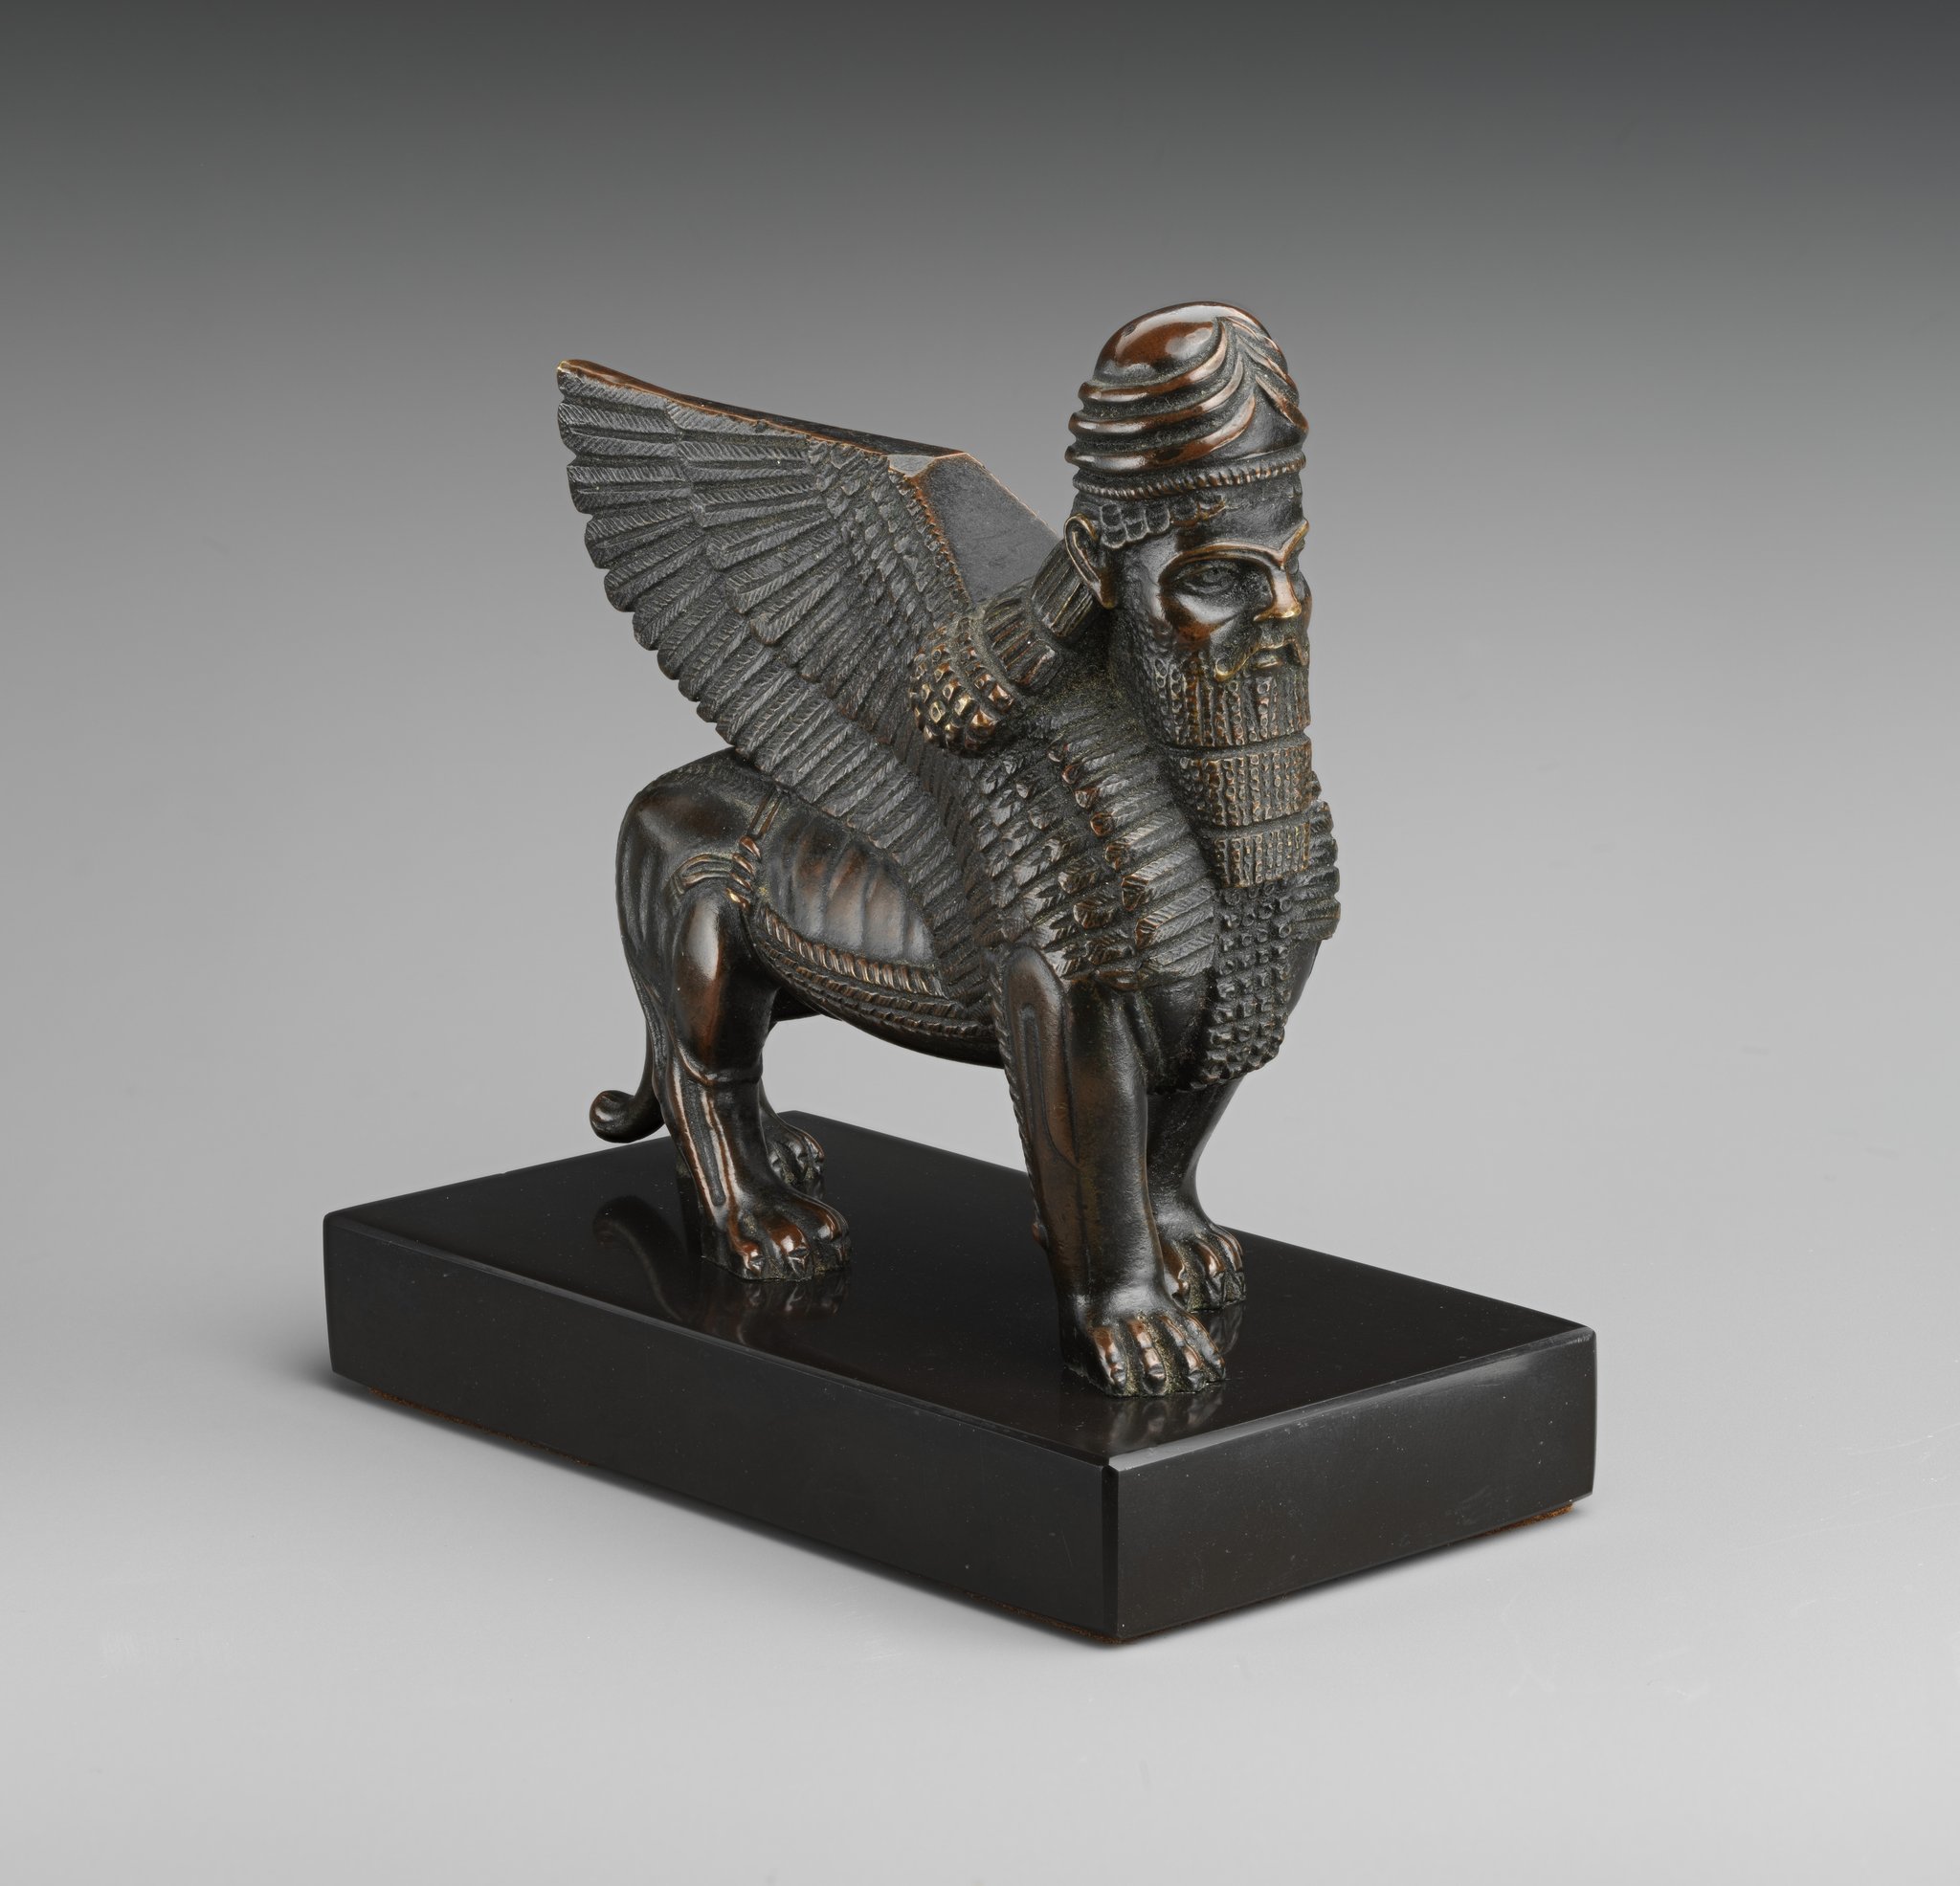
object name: winged lion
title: Human-headed winged lion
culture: british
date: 1850-1900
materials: bronze, marble